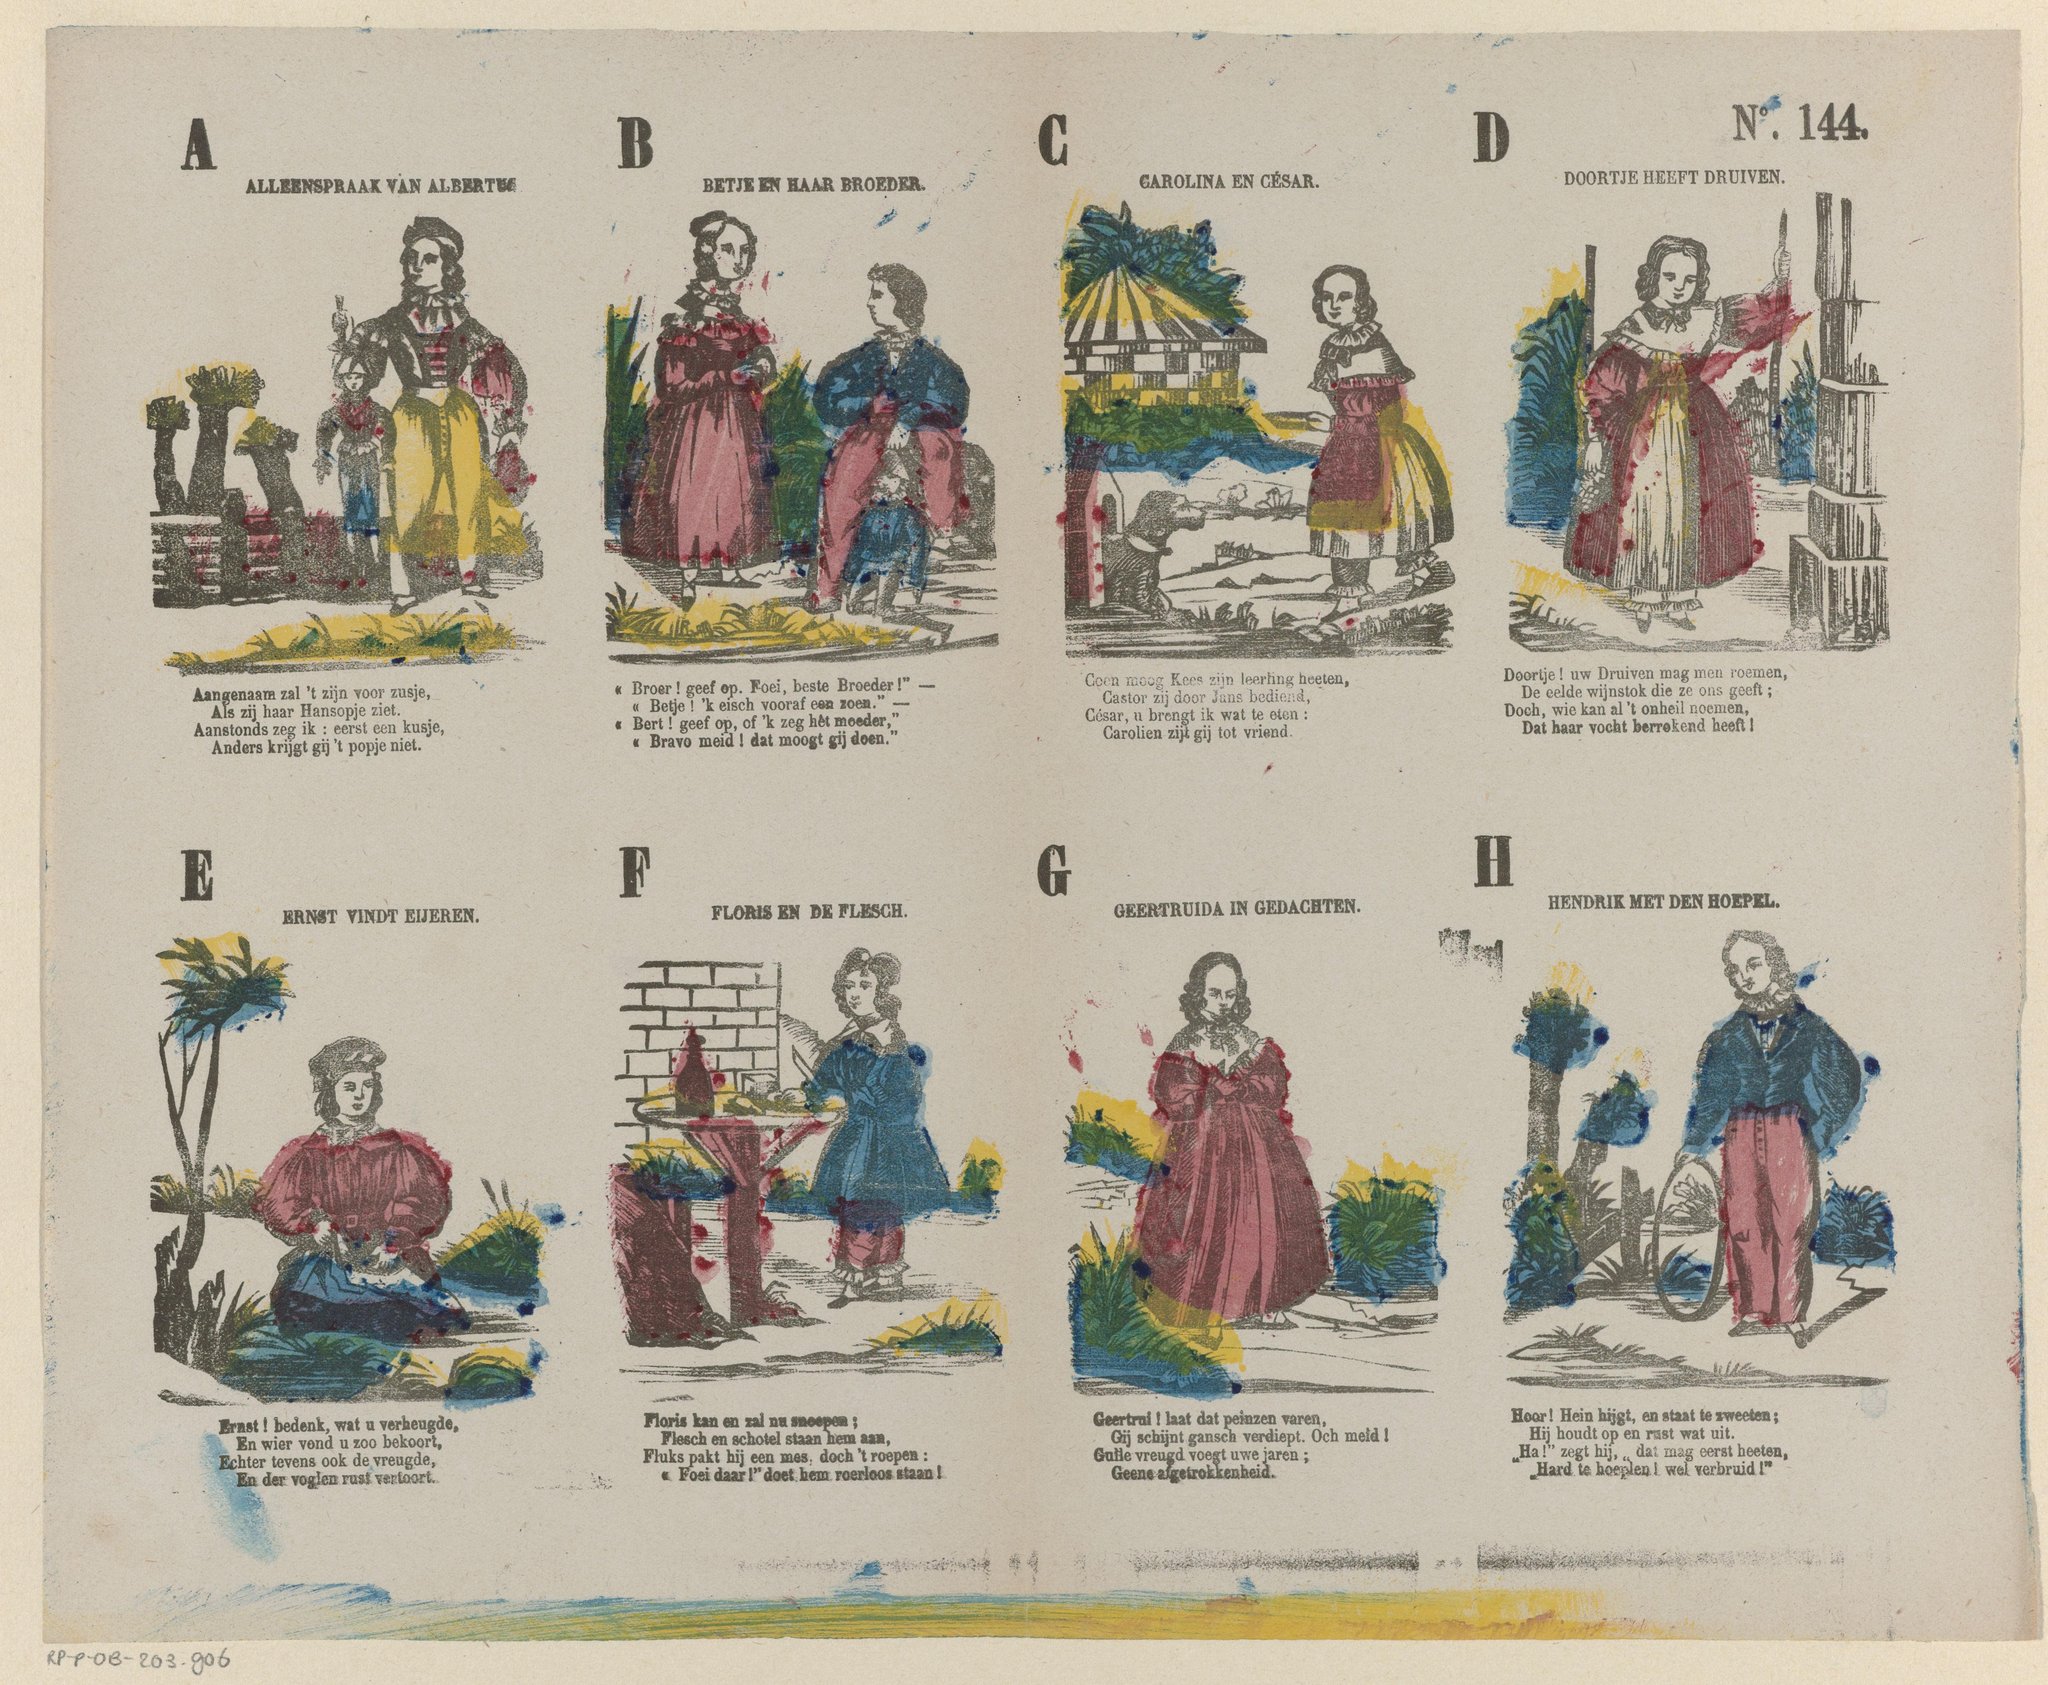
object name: popular print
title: Alfabet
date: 1827-1894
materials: paper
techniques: colour, letterpress printing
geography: schaarbeek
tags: letters, alphabet, script, child, characters (human types)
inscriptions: collector's mark: Lugt 2760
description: Blad met 8 voorstellingen van de letters van het alfabet (A-H) geïllustreerd met figuren waarvan de namen met de betreffende letter beginnen. Onder elke afbeelding een vierregelig vers, boven elke afbeelding een titel. Genummerd rechtsboven: No. 144.